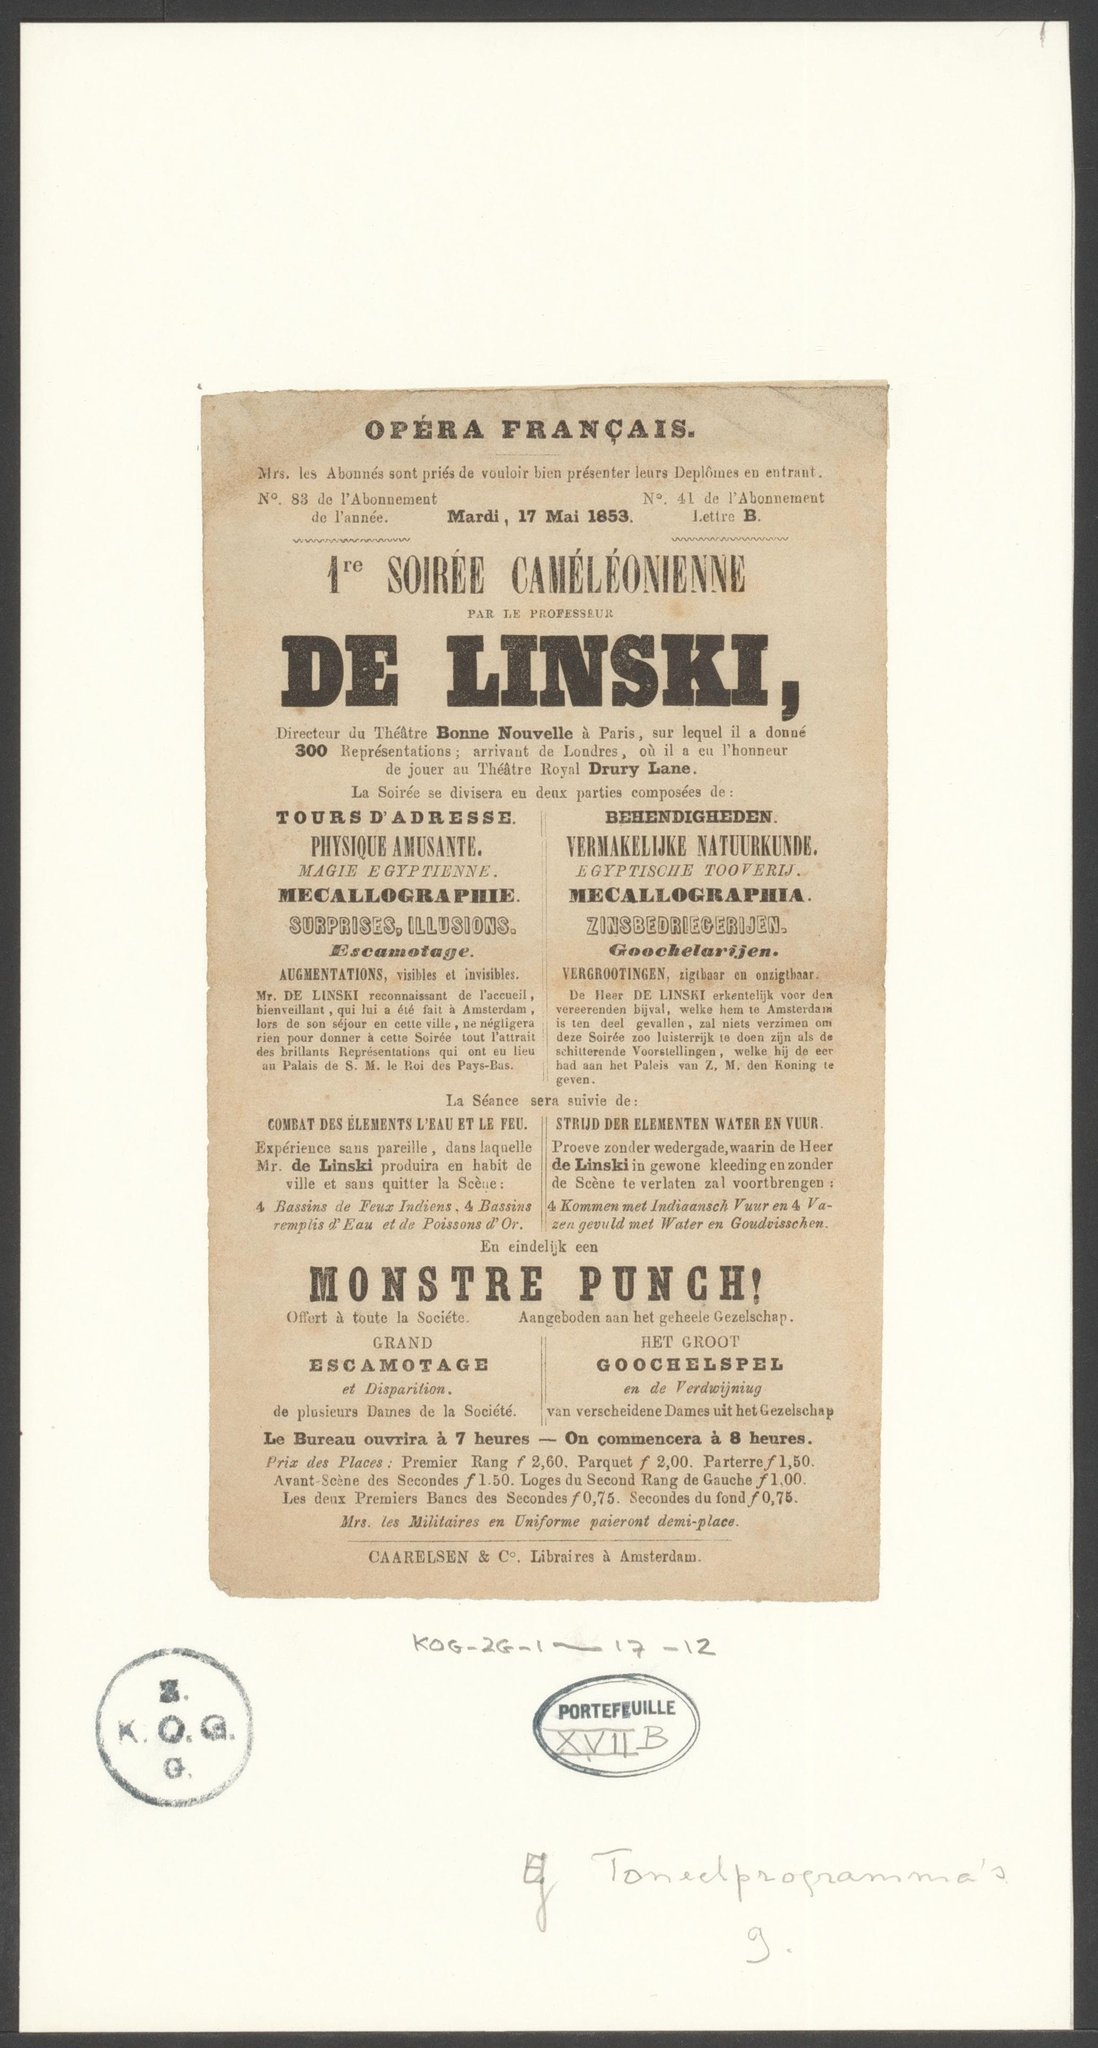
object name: text sheet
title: Programma voor de voorstelling van Professeur de Linski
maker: Anonymous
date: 1853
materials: paper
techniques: letterpress printing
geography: amsterdam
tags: theatre, theatrical performance, art, amsterdam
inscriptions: stamp, collector's mark: Lugt 1641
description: De voorstelling vindt plaats in de Opéra Français op 17 mei 1853. Onderwerpsrubrieken binnen de Atlas Zeden en Gewoonten: Tooneel, Toneelprogramma’s.